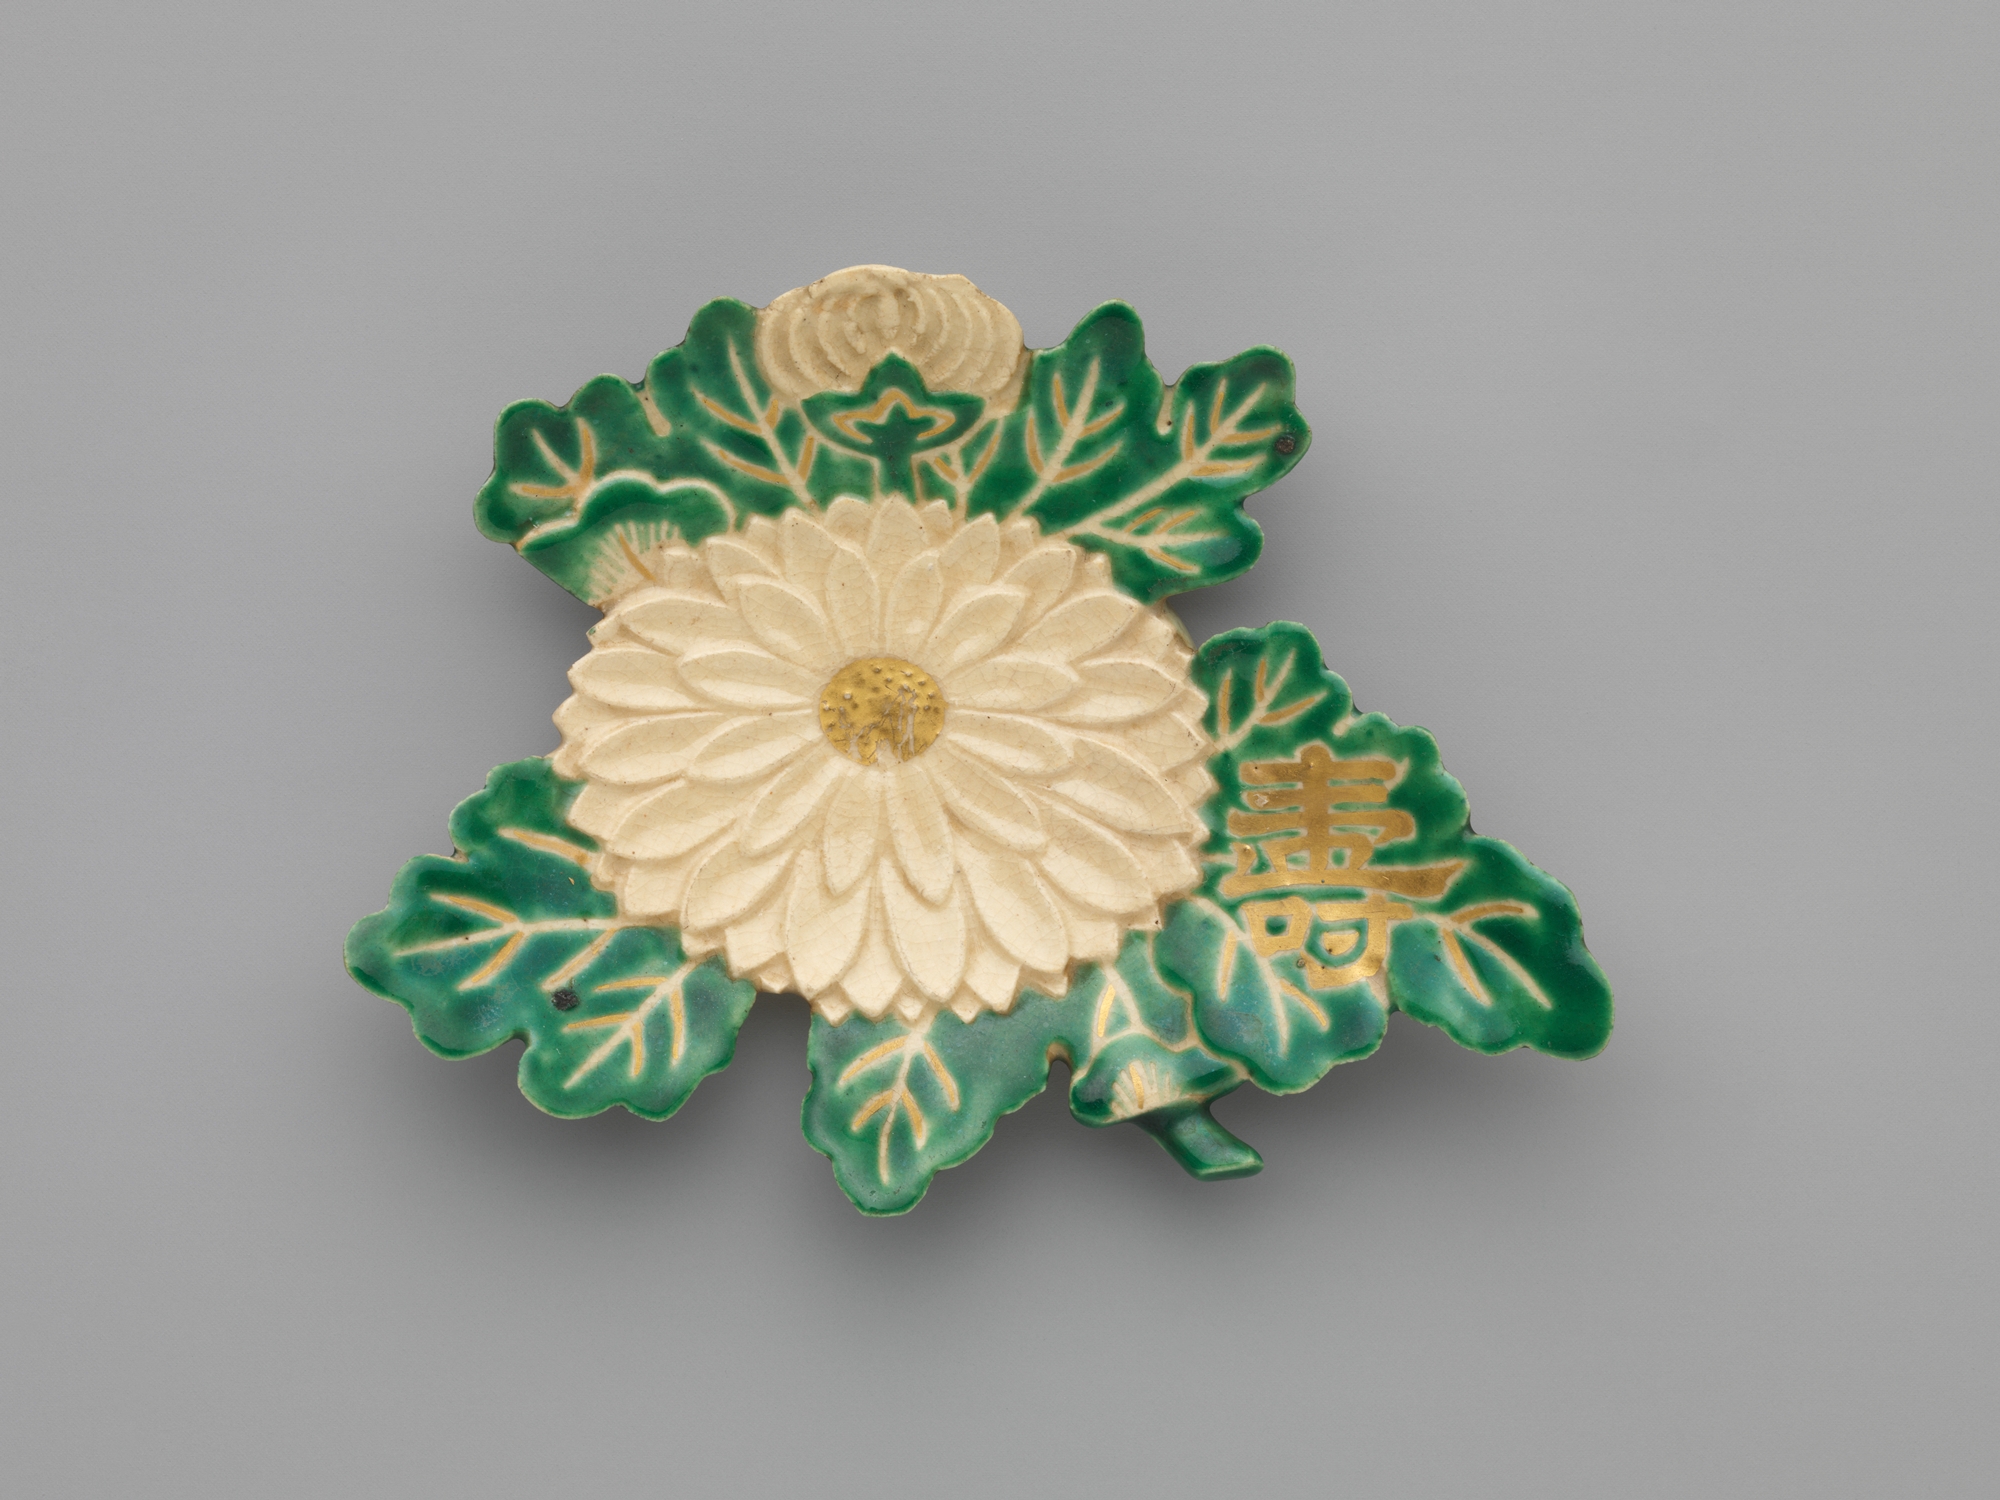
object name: dish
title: Kenzan-style Dish in the Shape of Chrysanthemum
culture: japanese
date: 1801-1833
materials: enamel, stoneware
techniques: overglaze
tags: leaves